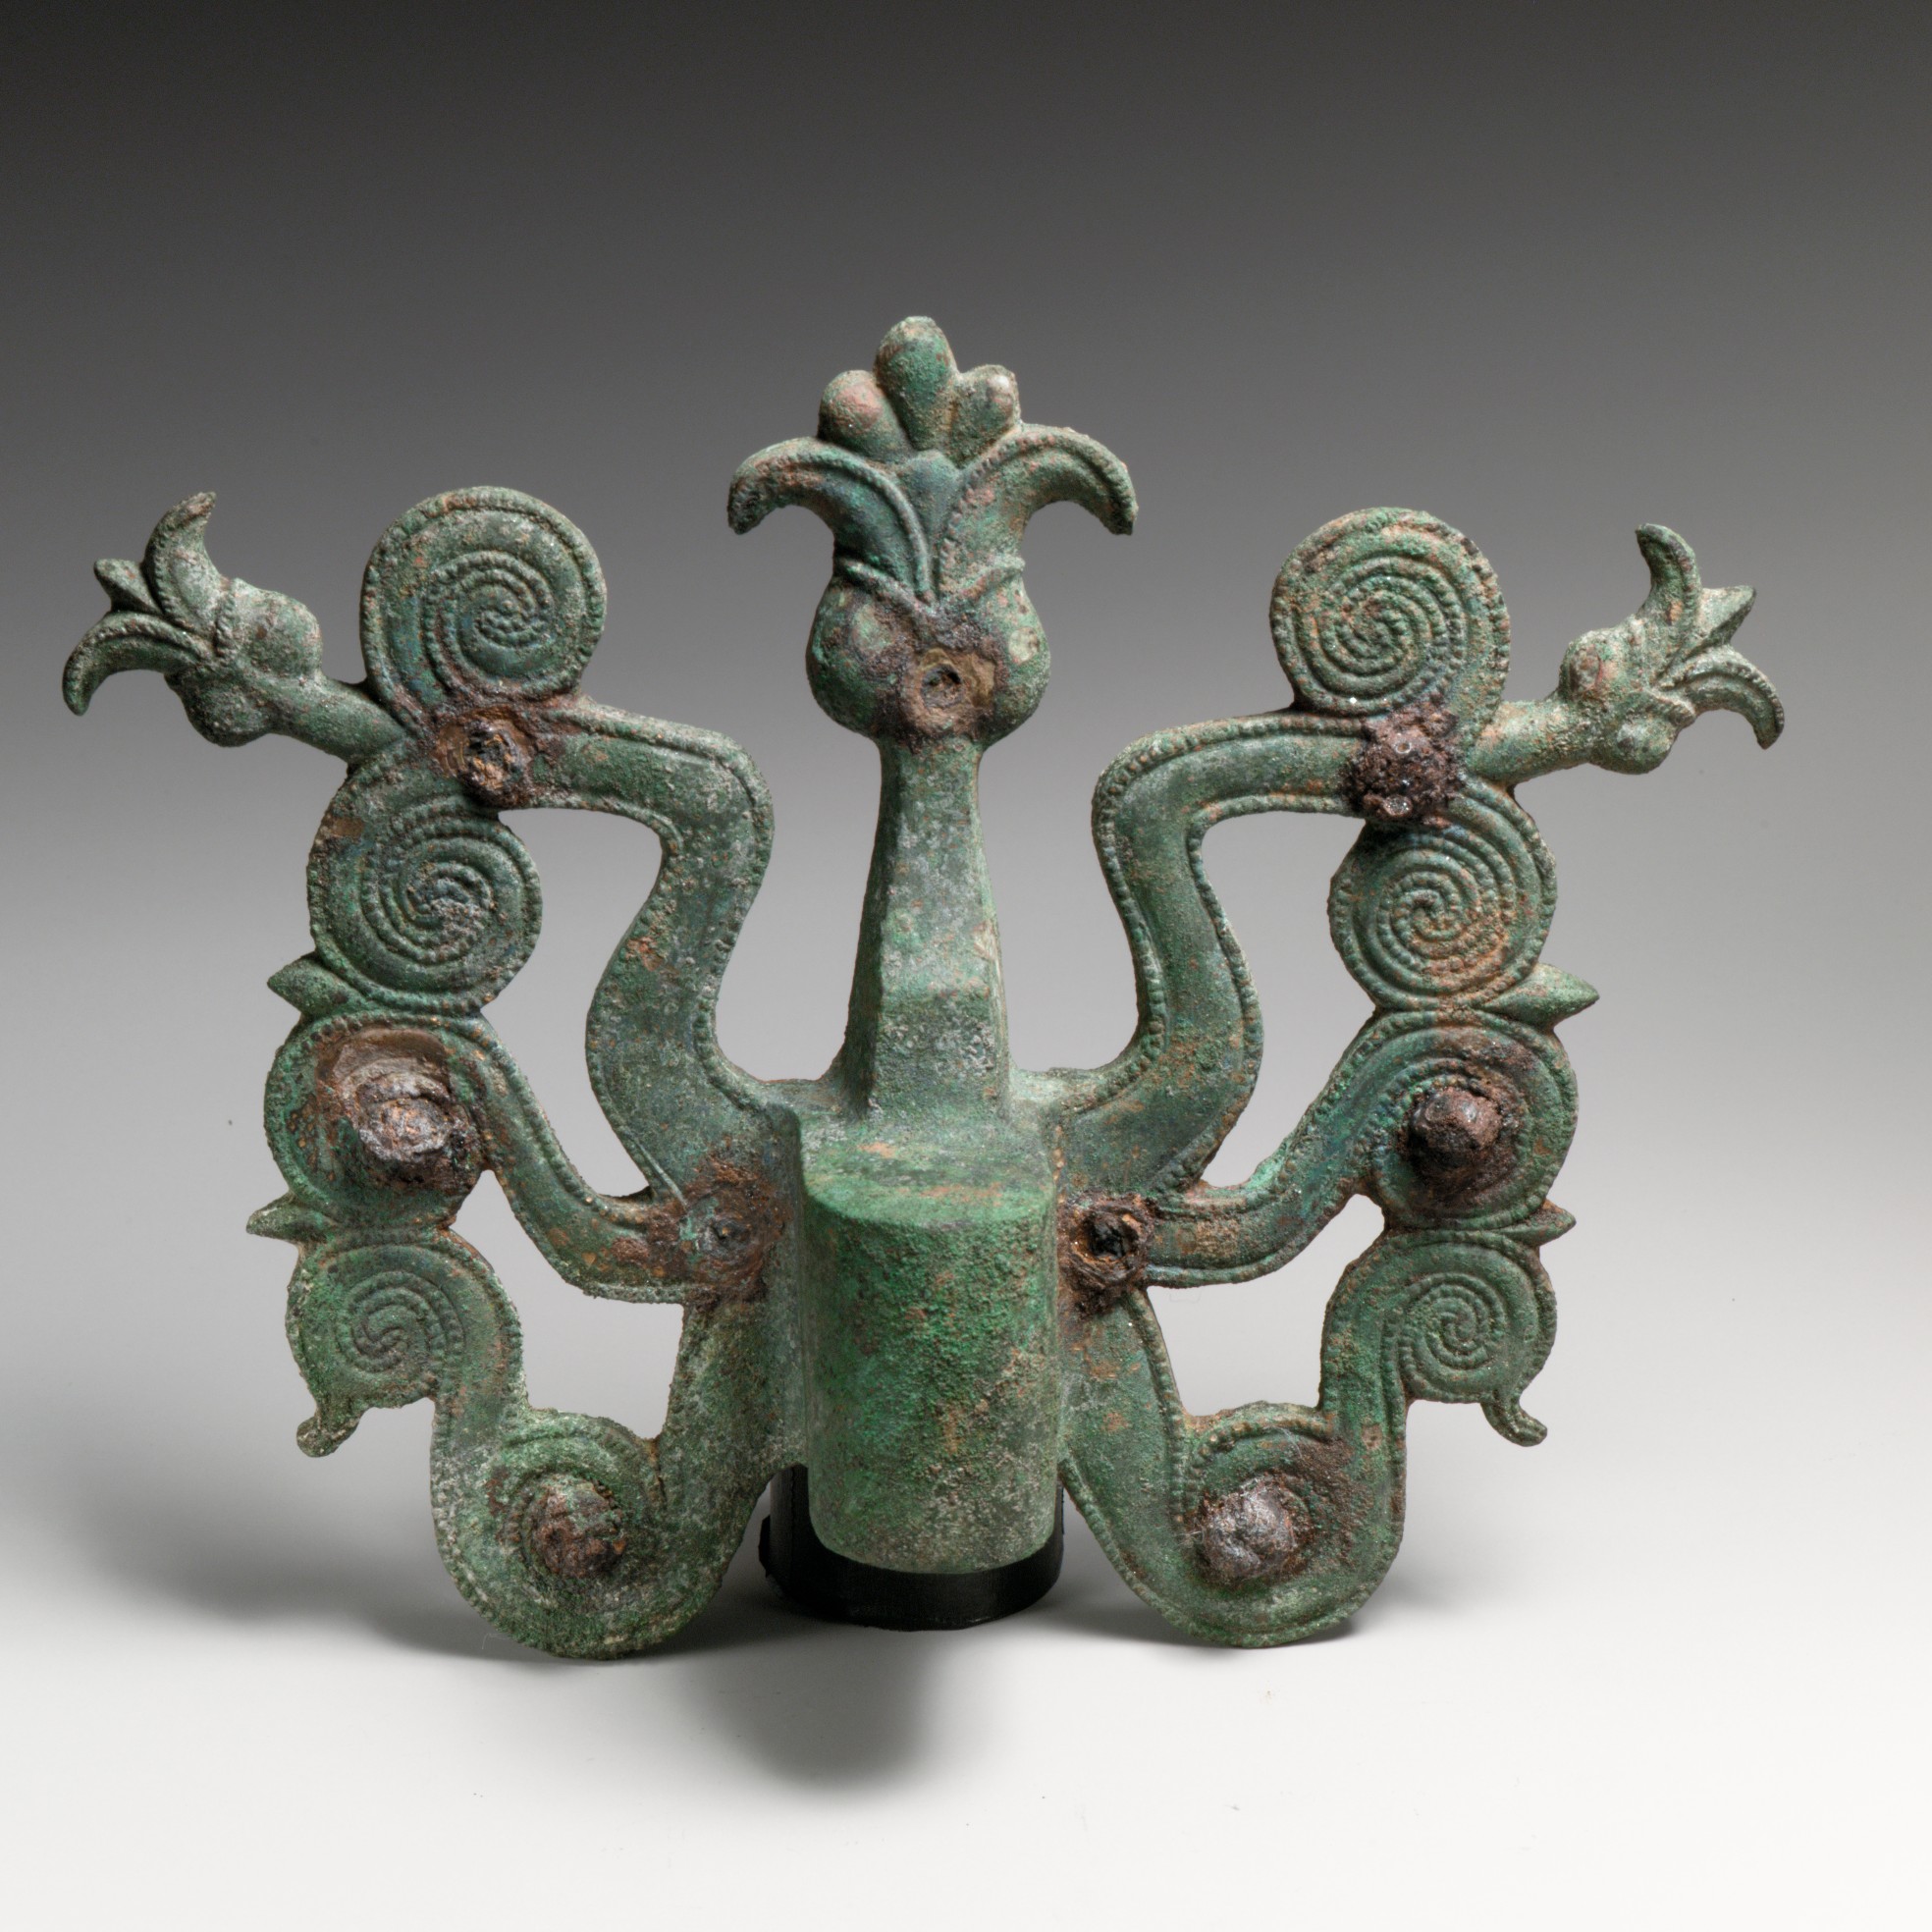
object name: chariot fragment, socket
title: Fragments of a cart or chariot, sockets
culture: etruscan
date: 500-480 BCE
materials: bronze, iron